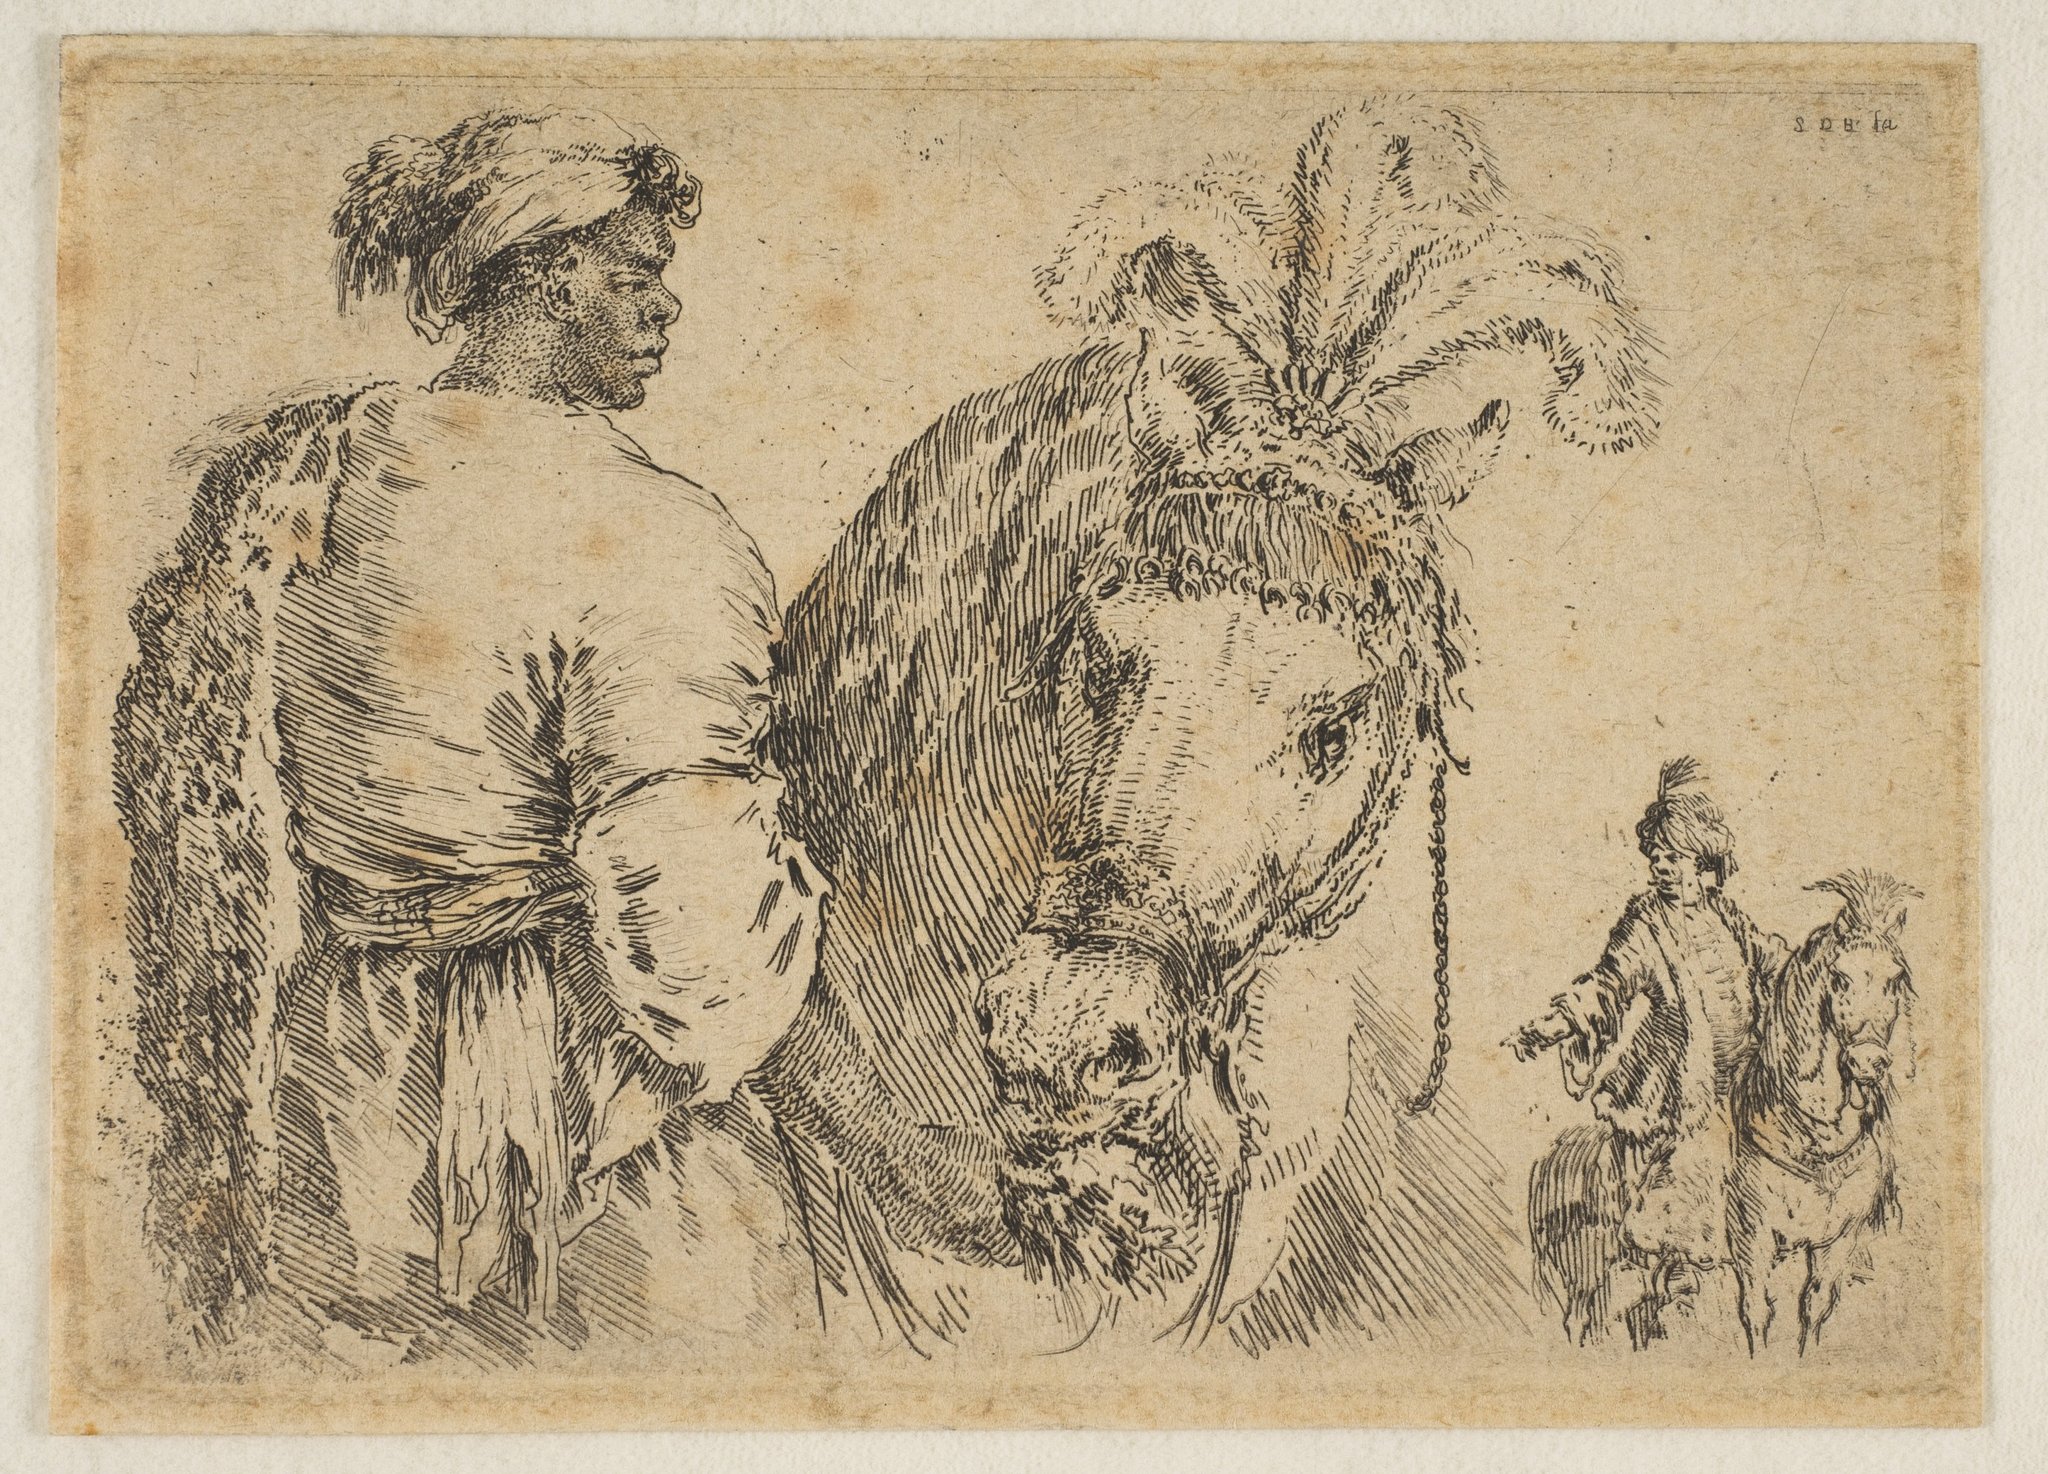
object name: print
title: A Black Man Feeding a Horse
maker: stefano della bella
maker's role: artist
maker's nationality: italian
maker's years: 1610-1664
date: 1662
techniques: etching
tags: men,horses